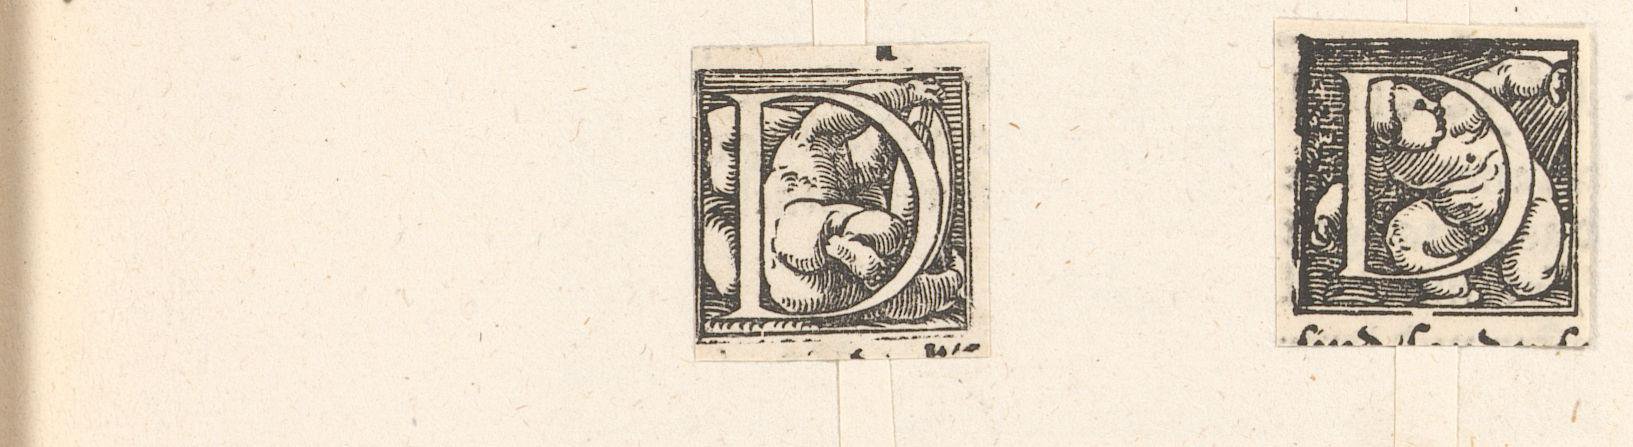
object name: print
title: Initiaal D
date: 1524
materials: paper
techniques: metal cut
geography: switzerland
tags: initial, falling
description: Dit initiaal mogelijk gebruikt in: Das Alte Testament Deutsch ..., Basel: A. Petri, december 1523. Ook in latere publicaties van Petri werd het initiaal gebruikt.